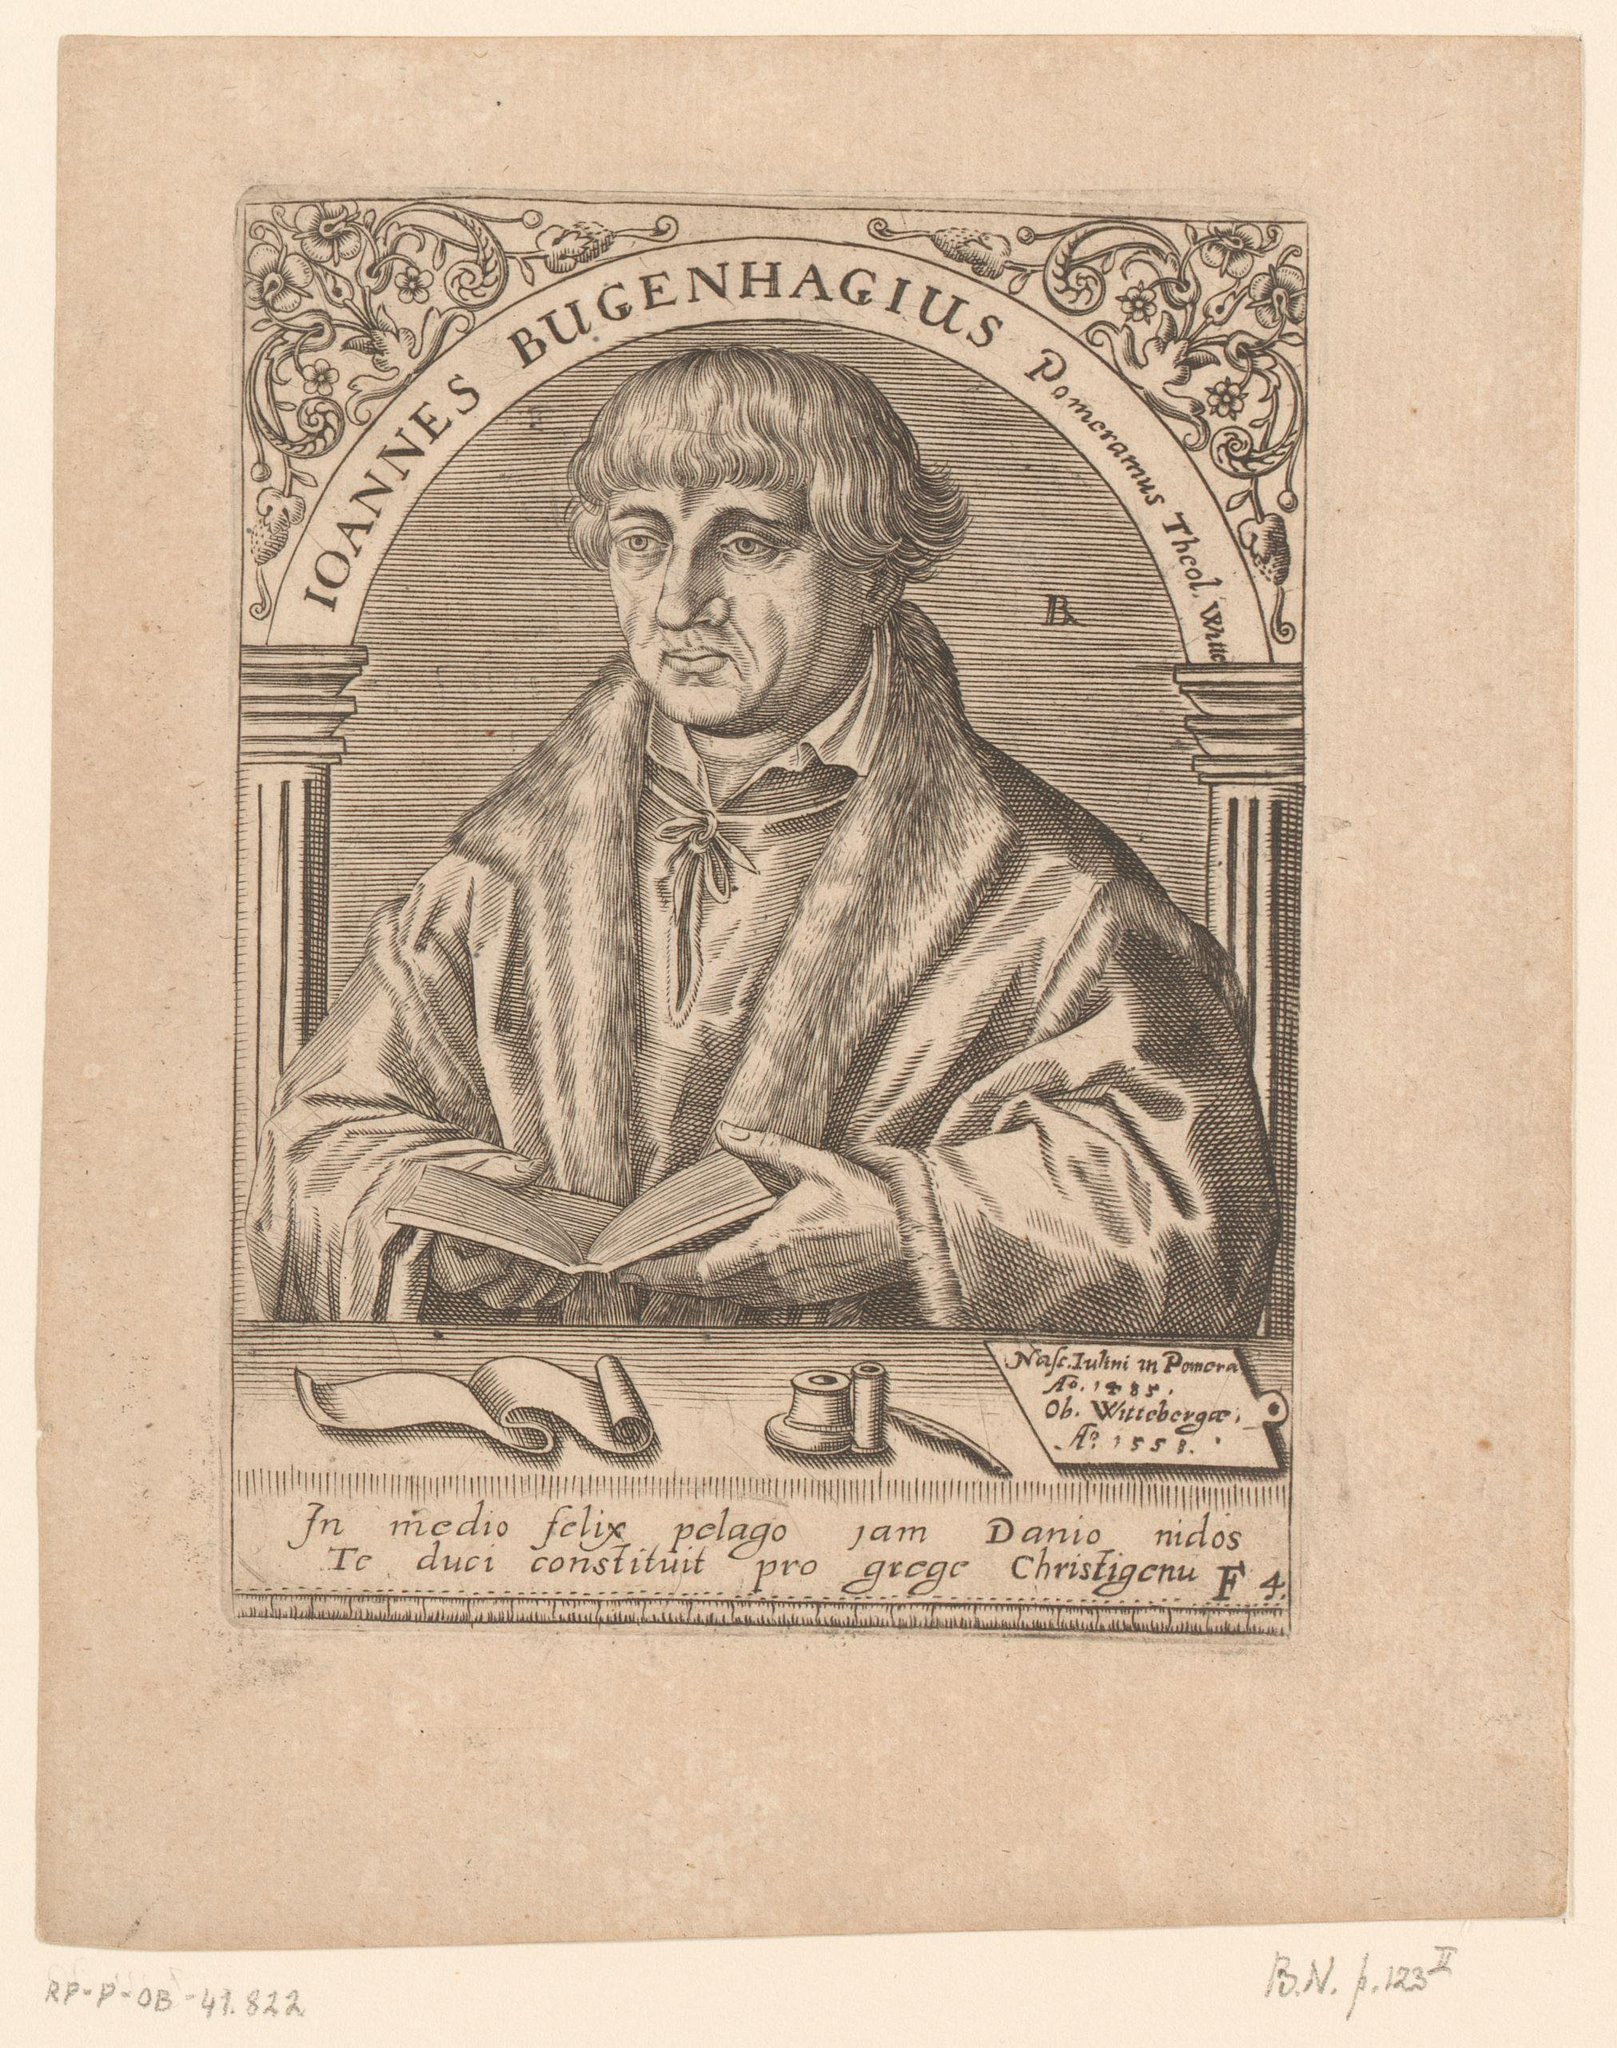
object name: print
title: Joannes Bugenhagius Pomeramus Theo. Witte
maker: robert boissard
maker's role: print maker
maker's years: 1570-1611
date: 1597-1599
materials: paper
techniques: engraving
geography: france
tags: ink-well, historical persons, book - mm - book open